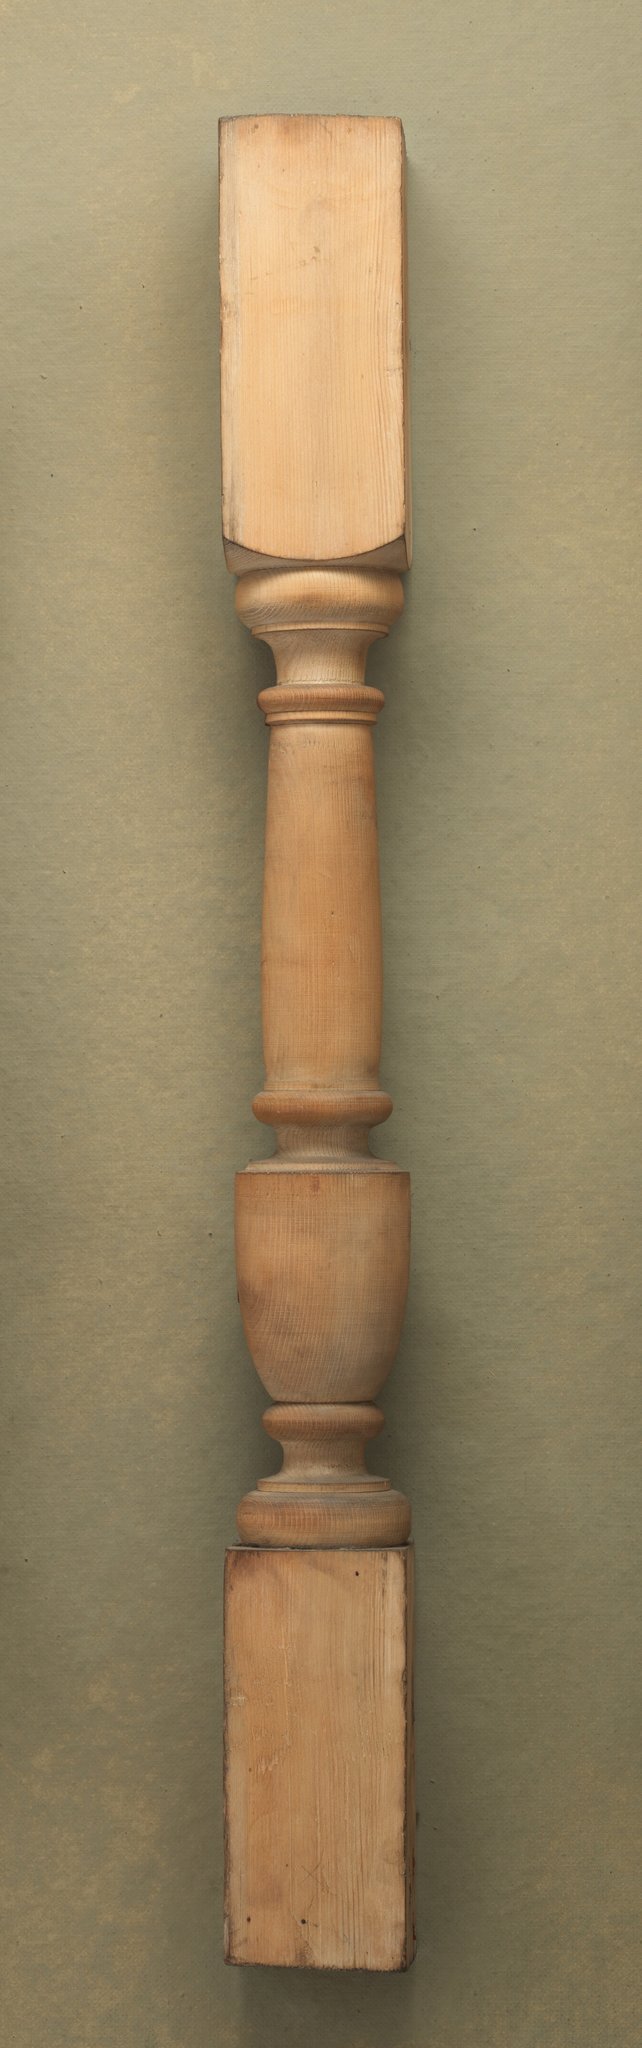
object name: baluster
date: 1667-1733